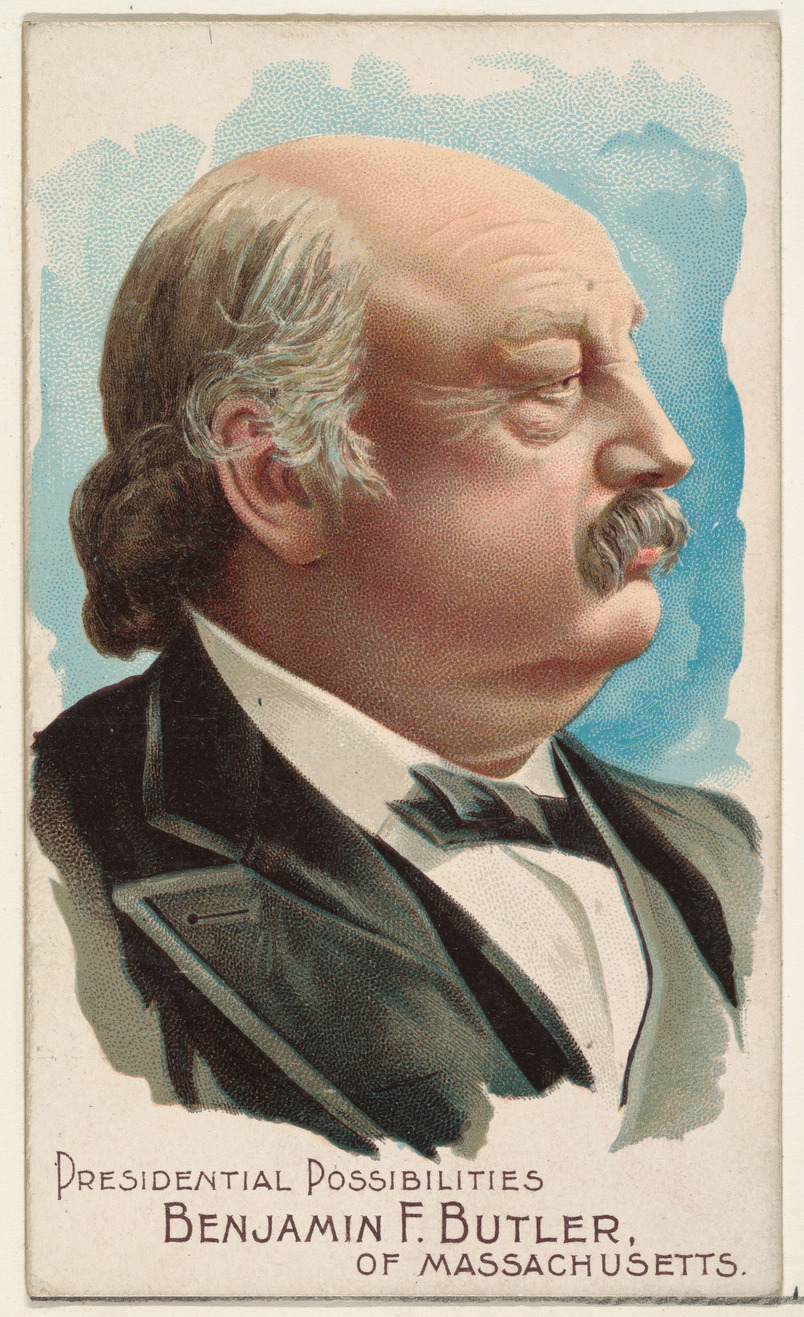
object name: print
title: Benjamin F. Butler of Massachusetts, from the Presidential Possibilities series (N124) issued by Duke Sons & Co. to promote Honest Long Cut Tobacco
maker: w. duke, sons & co.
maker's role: publisher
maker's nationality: american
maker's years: 1870-1920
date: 1888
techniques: color lithograph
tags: men,profiles,generals